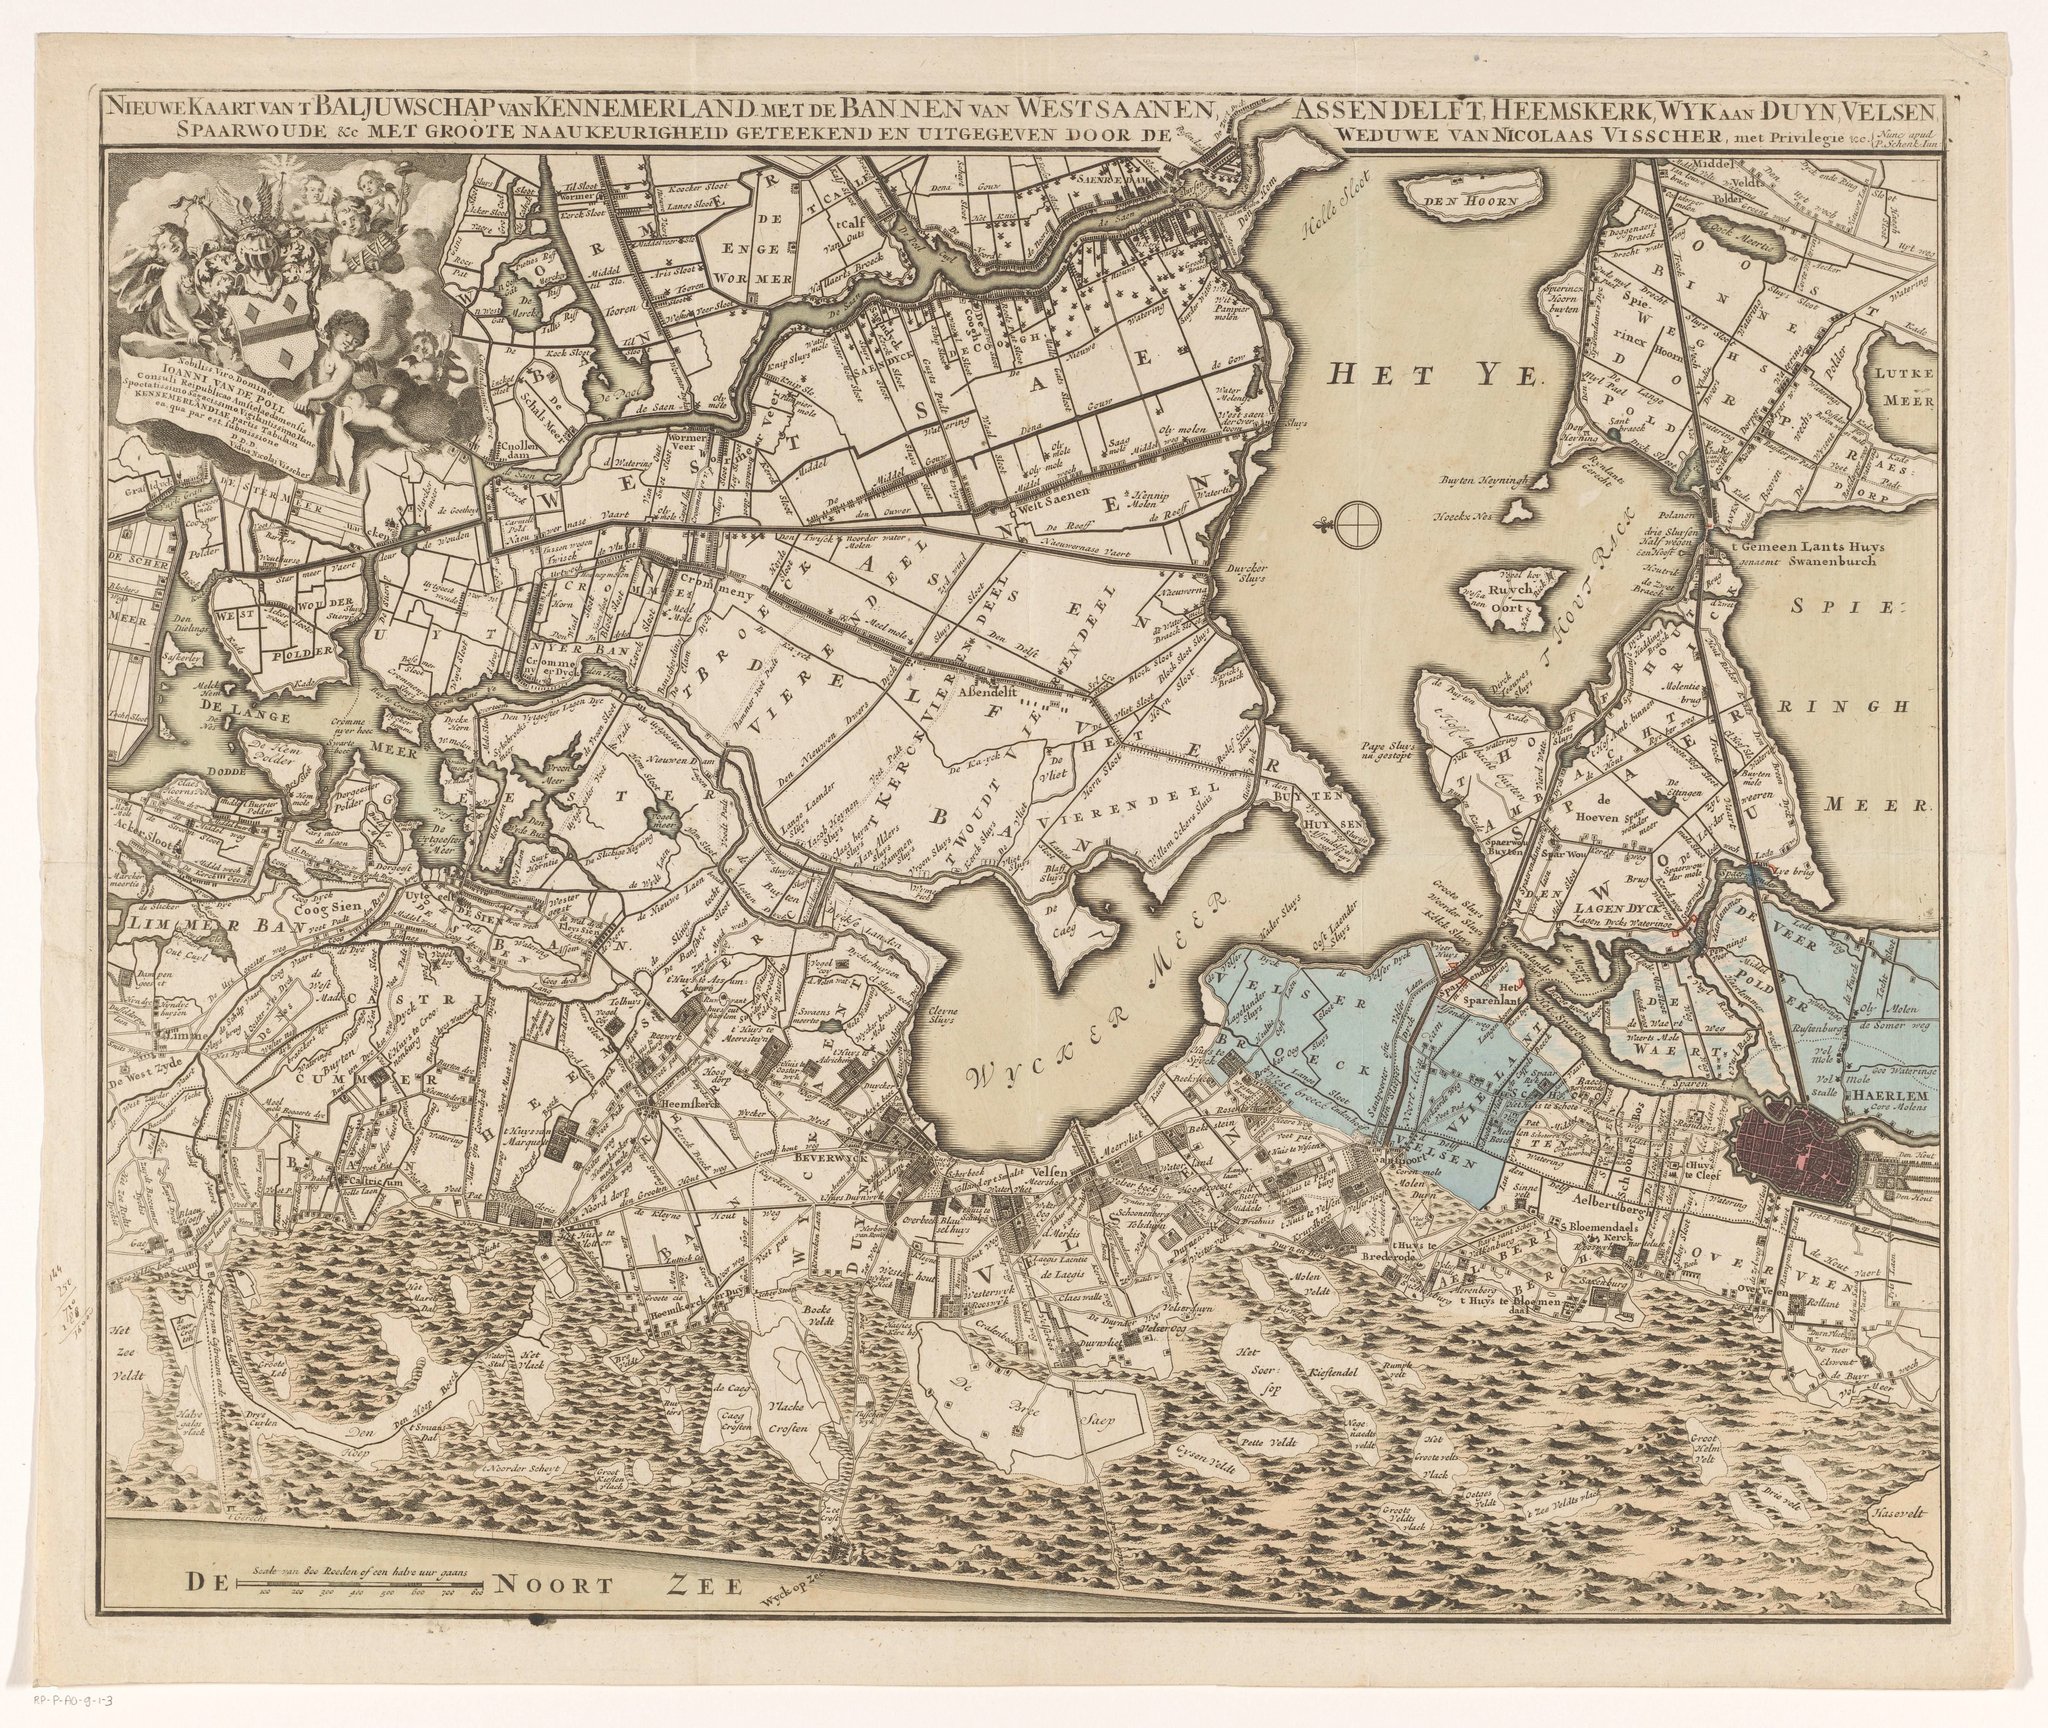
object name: print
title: Kaart van het baljuwschap Kennemerland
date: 1718-1726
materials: paper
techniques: engraving, etching, hand coloring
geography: amsterdam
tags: maps of separate countries or regions, maps of cities, armorial bearing, heraldry, haarlem, holland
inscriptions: collector's mark: Lugt 19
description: Kaart van het baljuwschap Kennemerland. Langs de bovenkant de titel. Linksboven de opdracht aan en het wapen van de Amsterdamse burgemeester J(o)an van de Poll (1666-1735) met daaromheen putti. Linksonder een schaalstok: Scale van 800 roeden of een halve uur gaans. Oriëntatie: het noorden links.